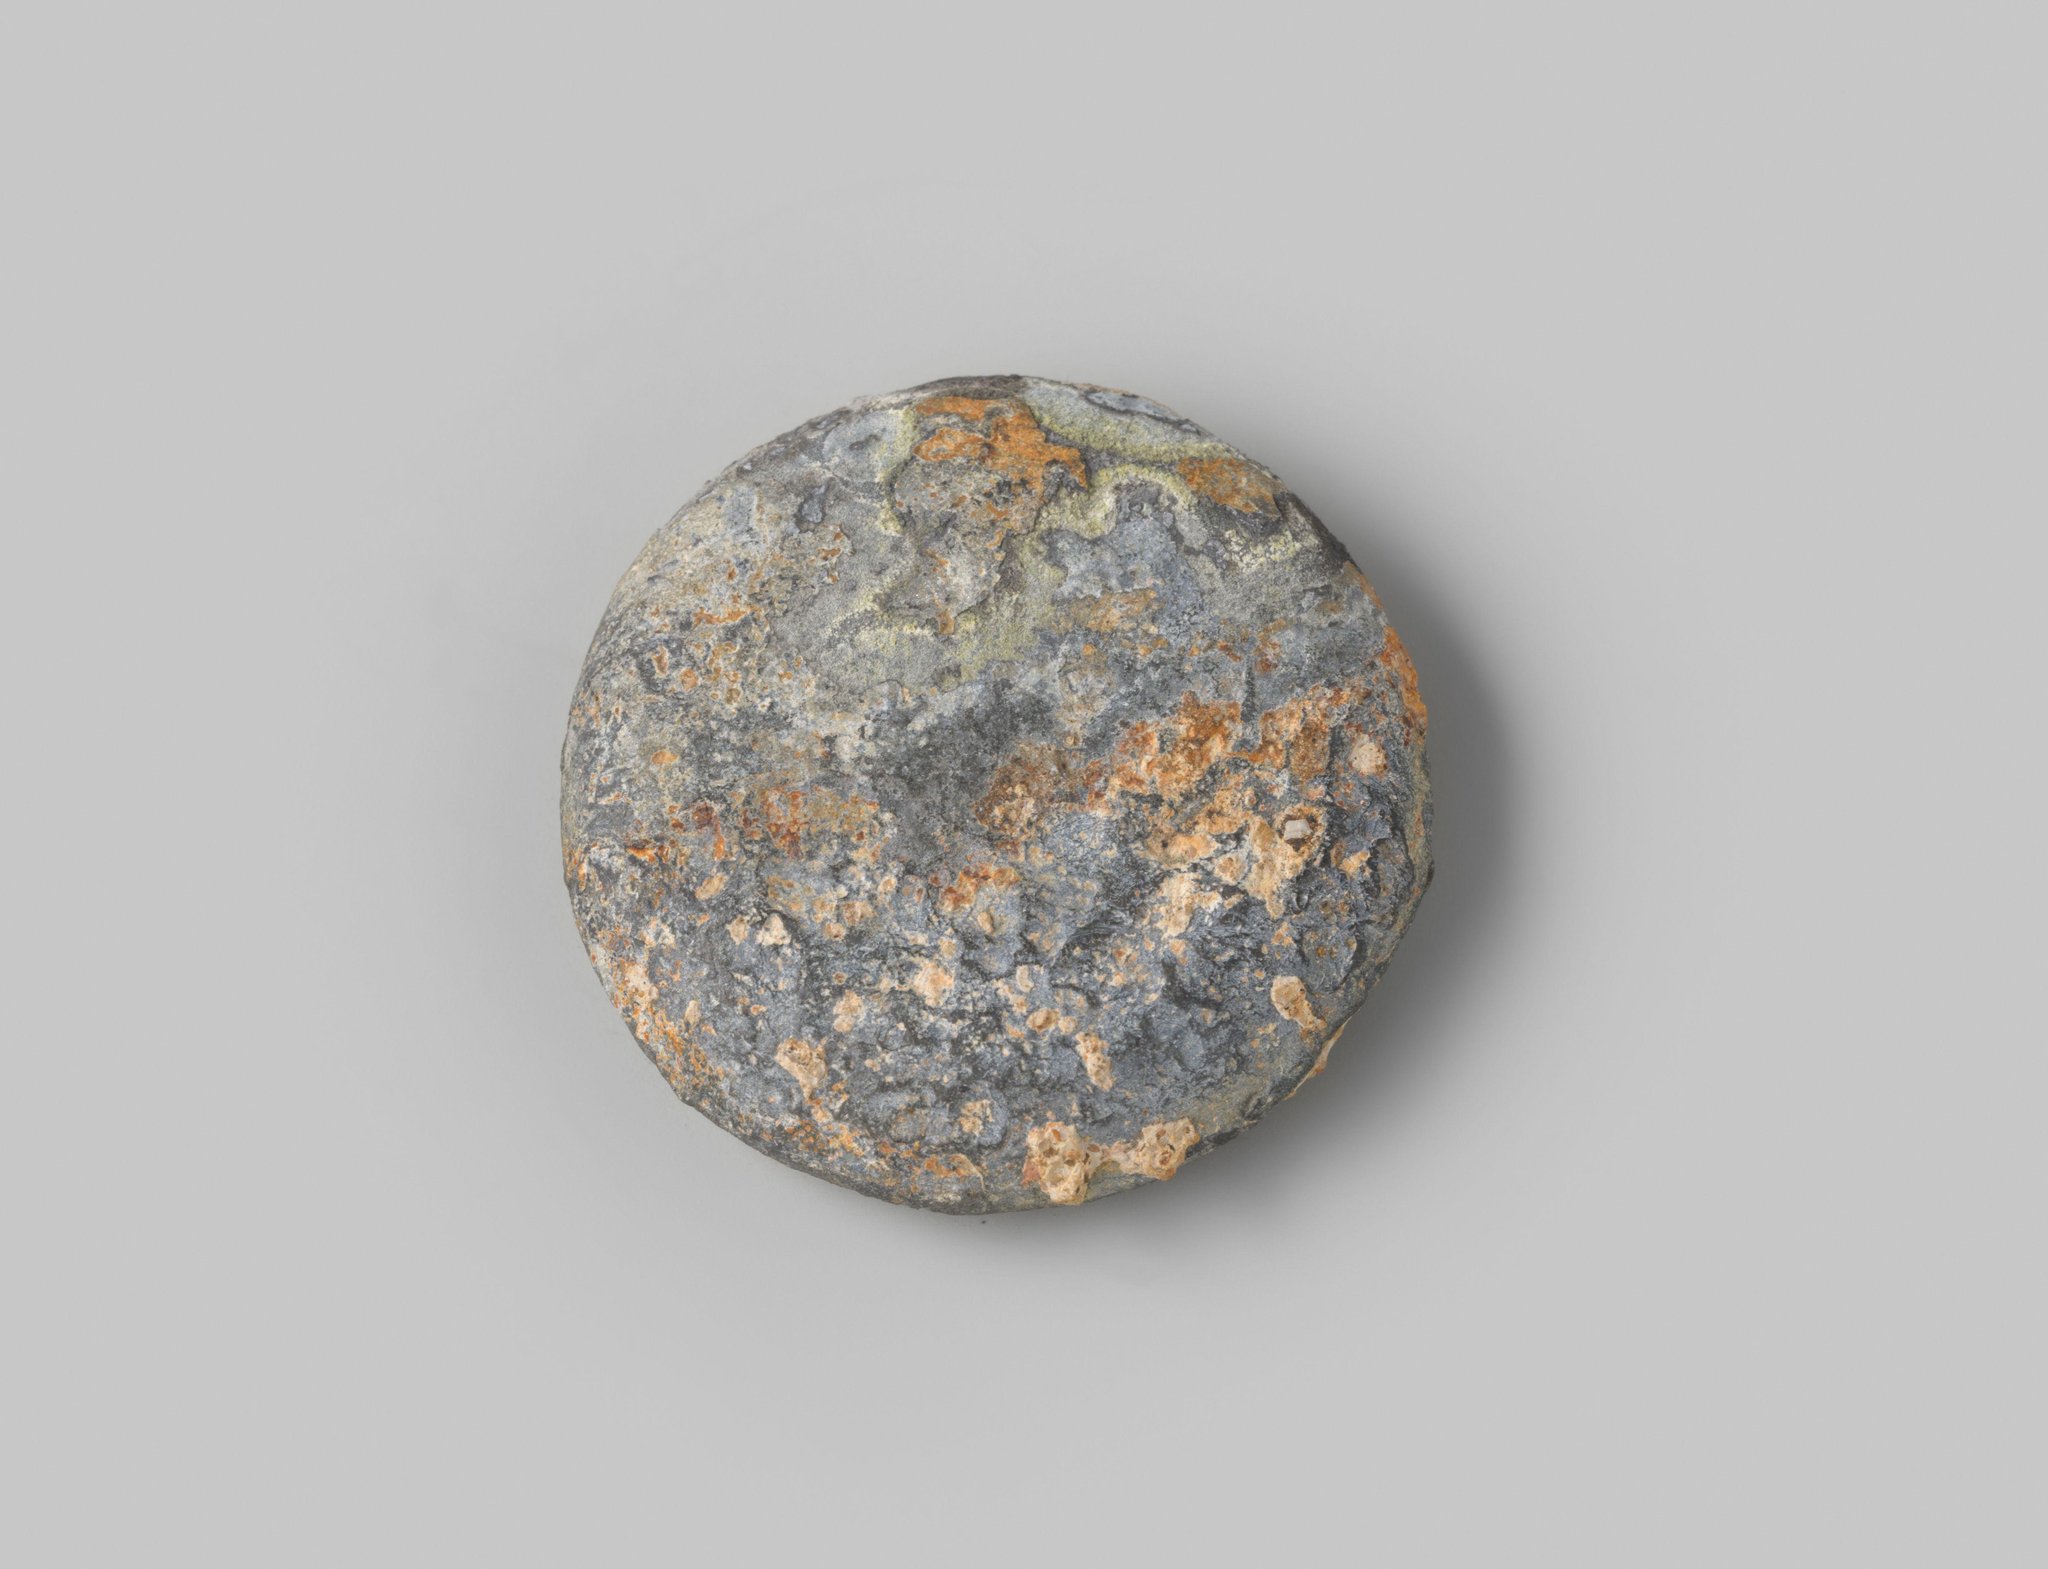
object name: weight scale component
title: Gewicht uit het wrak van de Oost-Indiëvaarder Hollandia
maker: Anonymous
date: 1700-1743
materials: lead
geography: netherlands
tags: verenigde oostindische compagnie, hollandia (schip), annet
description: Disc-shaped weight, circular, flat, rounded edge with circular groove, eroded.